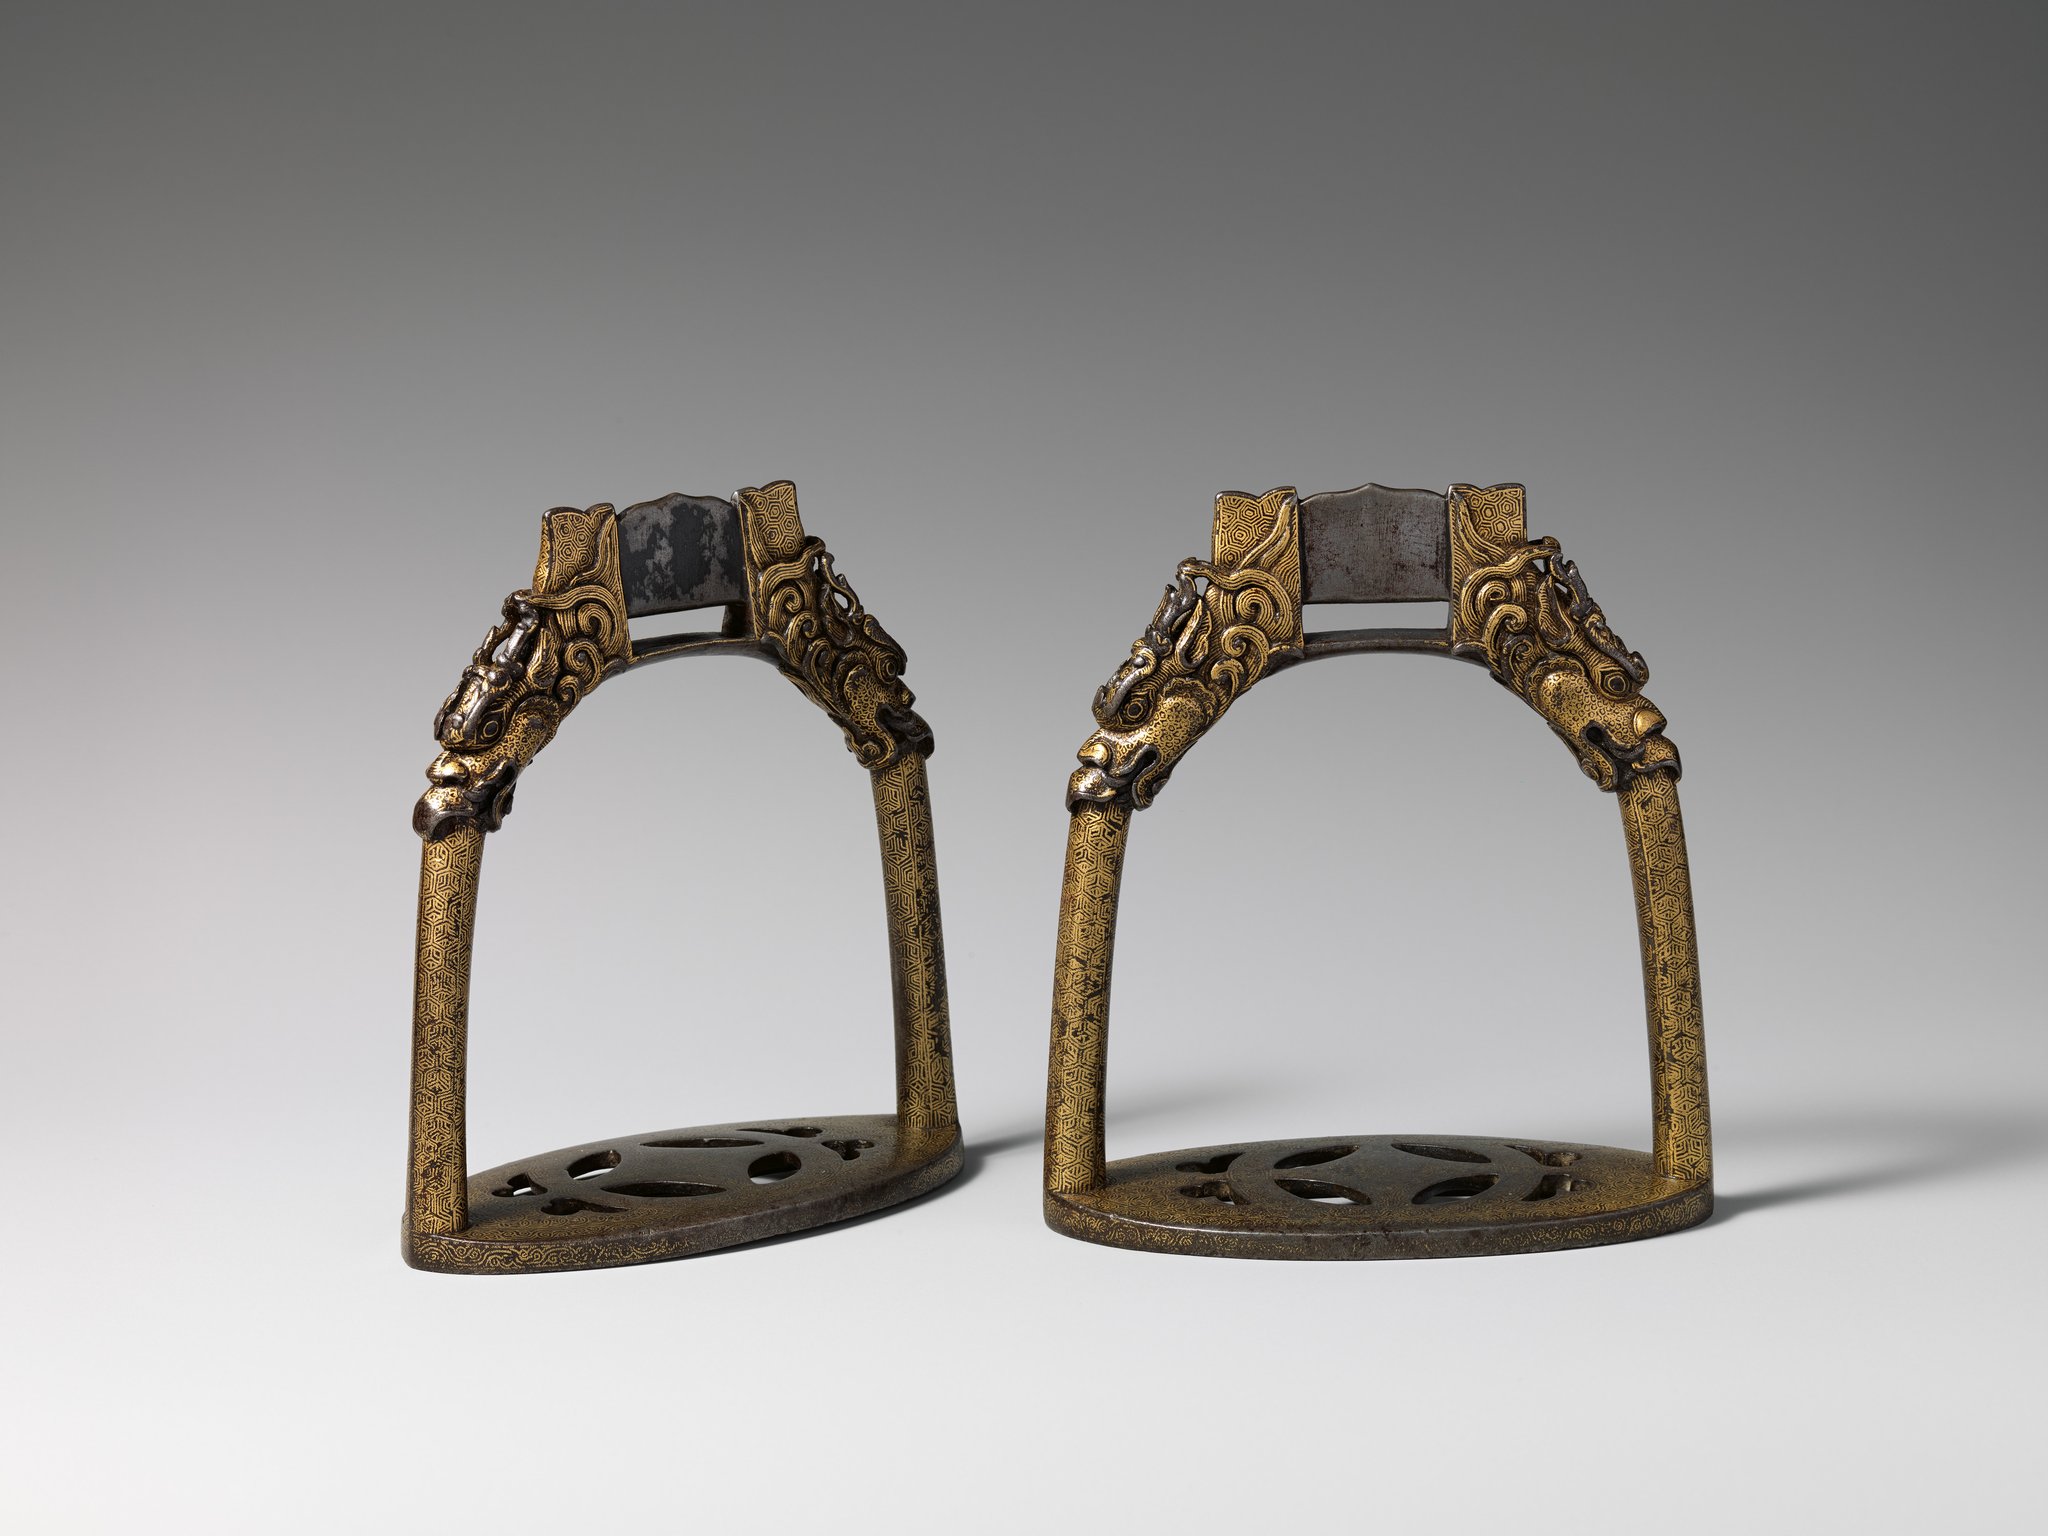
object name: pair of stirrup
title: Pair of Stirrups (清 鉄鑊金馬鐙一副)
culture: chinese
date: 1601-1700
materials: gold, iron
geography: china